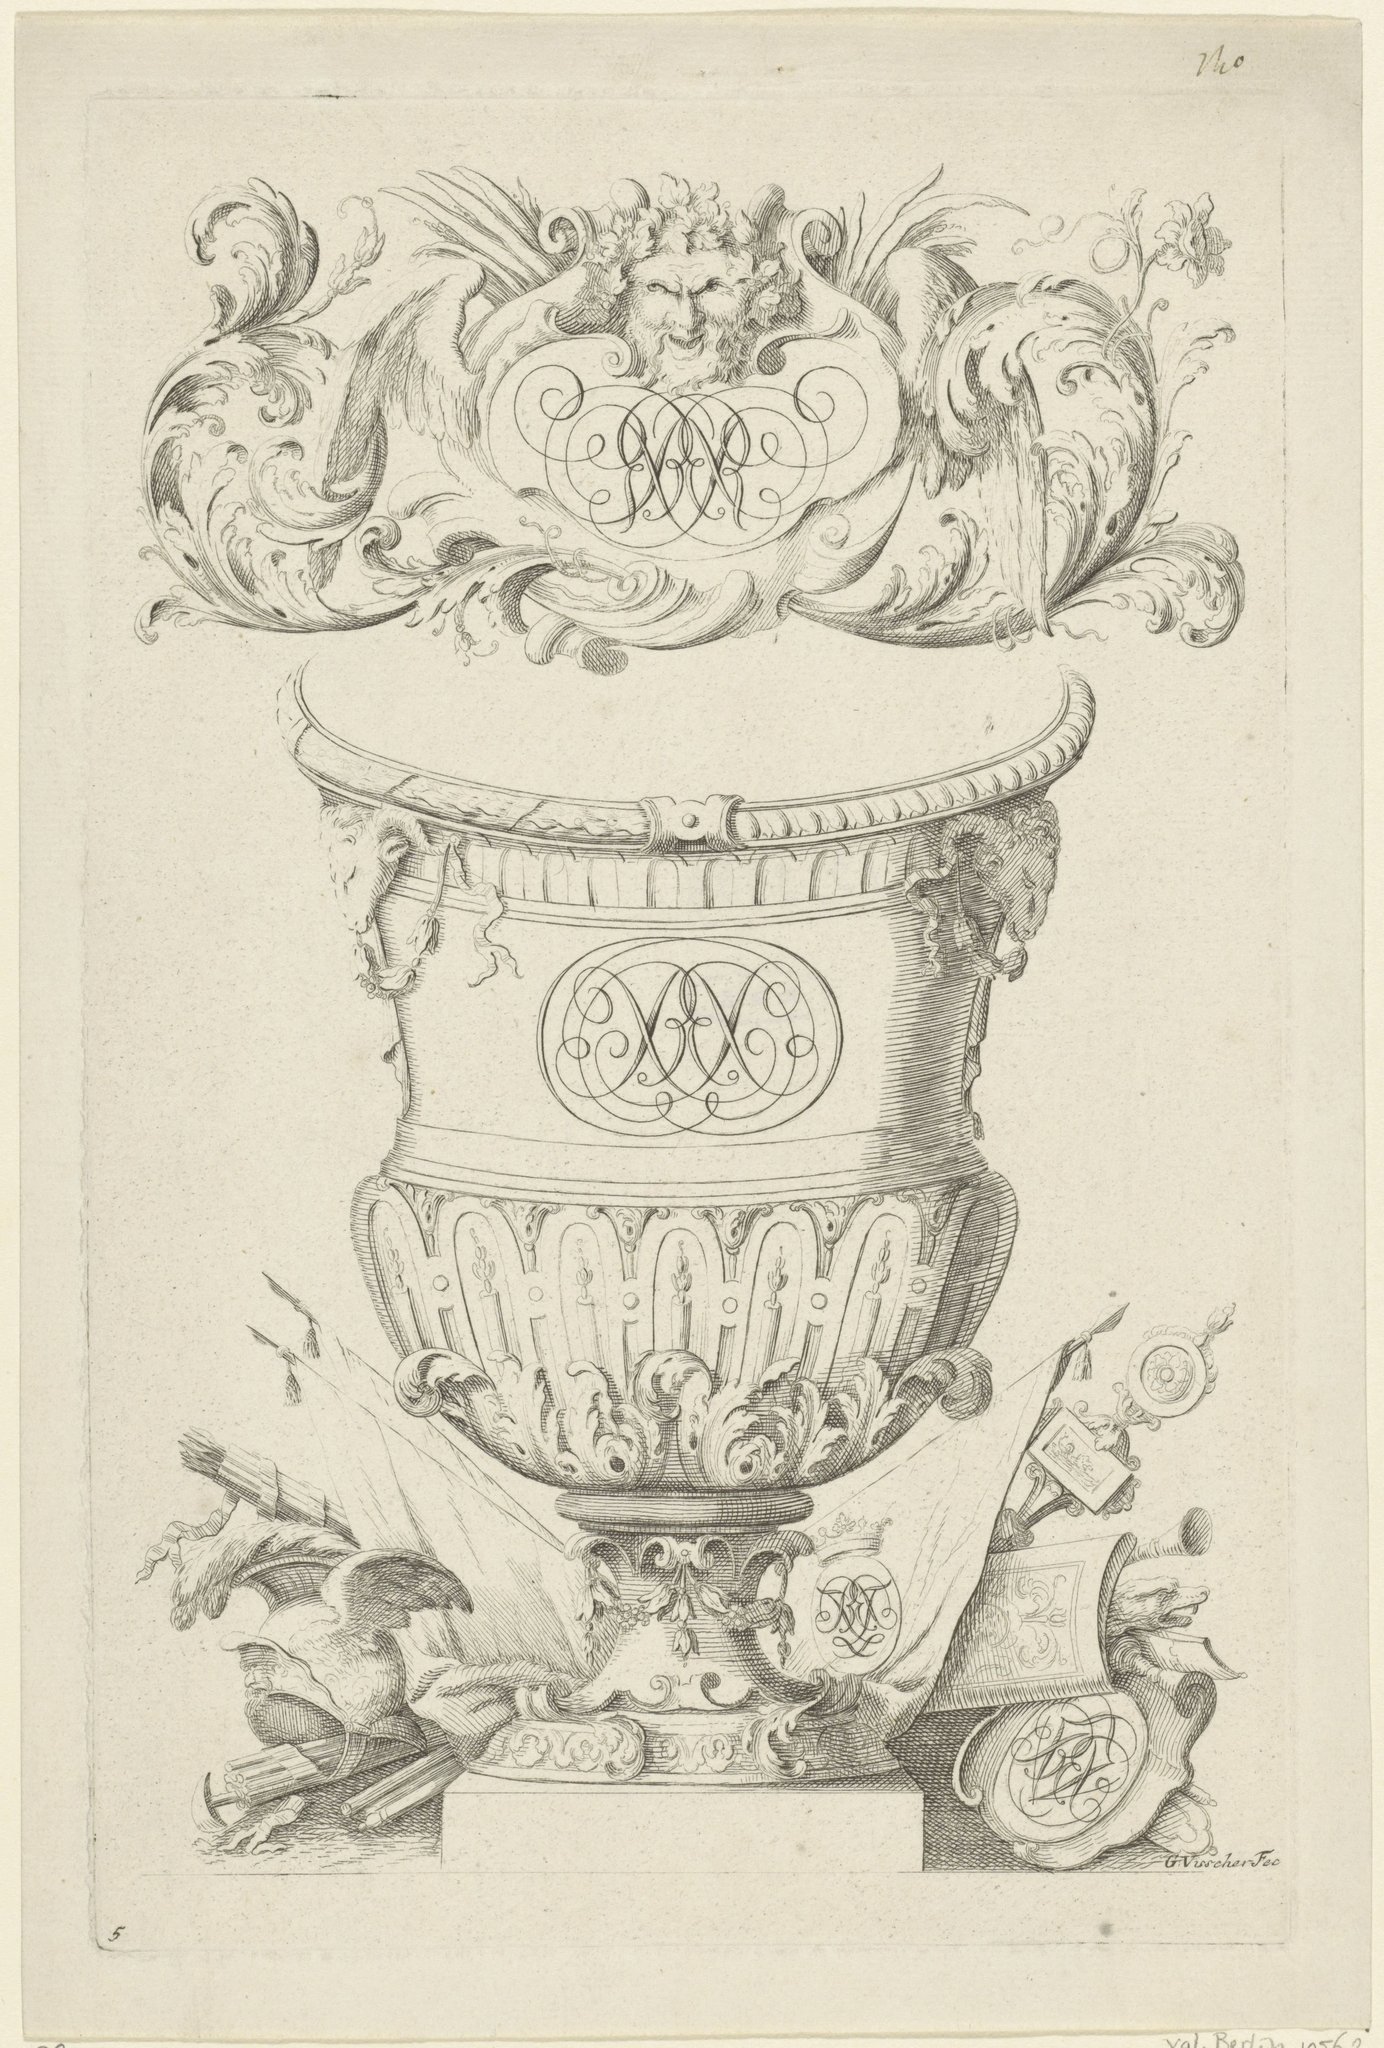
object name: ornament print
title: Het tweede deel Nieuwe t Samen gevlogte Naam Letteren Gemaakt door Gerrit Visscher tot Amsterdam op de Singel Bij de Beulingsluijs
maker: gerrit visscher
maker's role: print maker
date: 1690-1710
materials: paper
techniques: engraving, etching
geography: amsterdam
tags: anthropomorphic ornament, ram's head ~ ornament, garden vase, letter combinations such as letterword, anagram, letter square, monogram, etc.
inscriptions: collector's mark: Lugt 2228